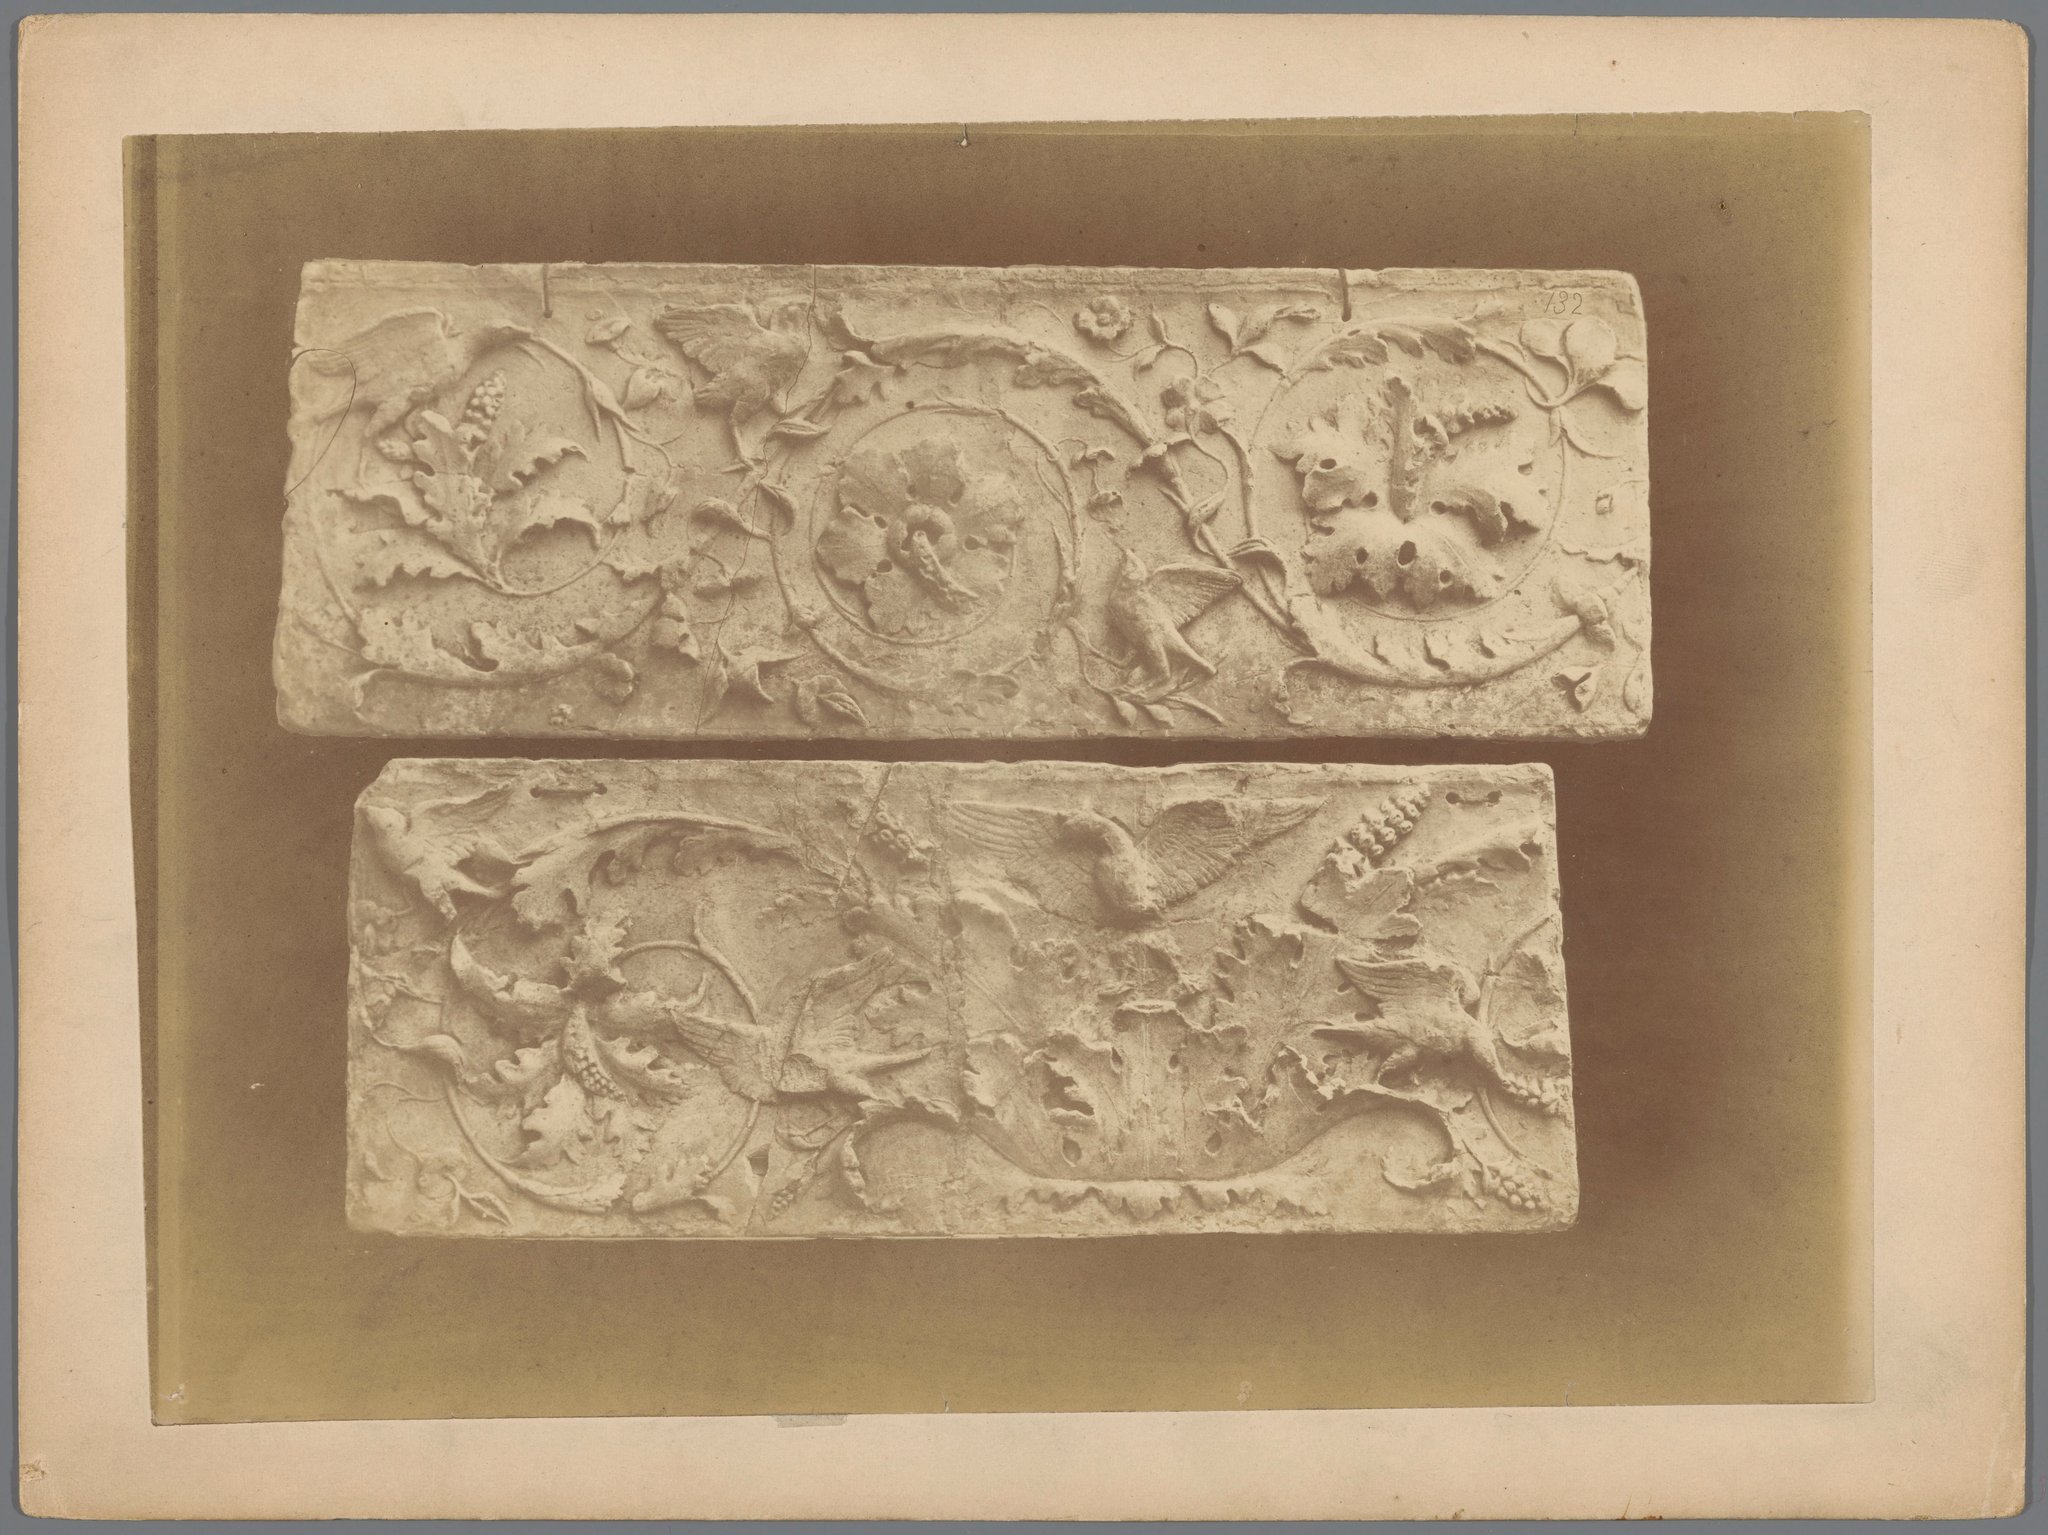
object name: photograph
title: Twee reliëfs met plantmotieven en vogels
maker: Anonymous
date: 1875-1900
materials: cardboard, photographic support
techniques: albumen print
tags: flowers ~ ornament - aa - stylized, ornamental birds, ornament derived from plant forms, sculpture (+ relief ~ sculpture)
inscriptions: collector's mark: Lugt 3937, number: ‘132’